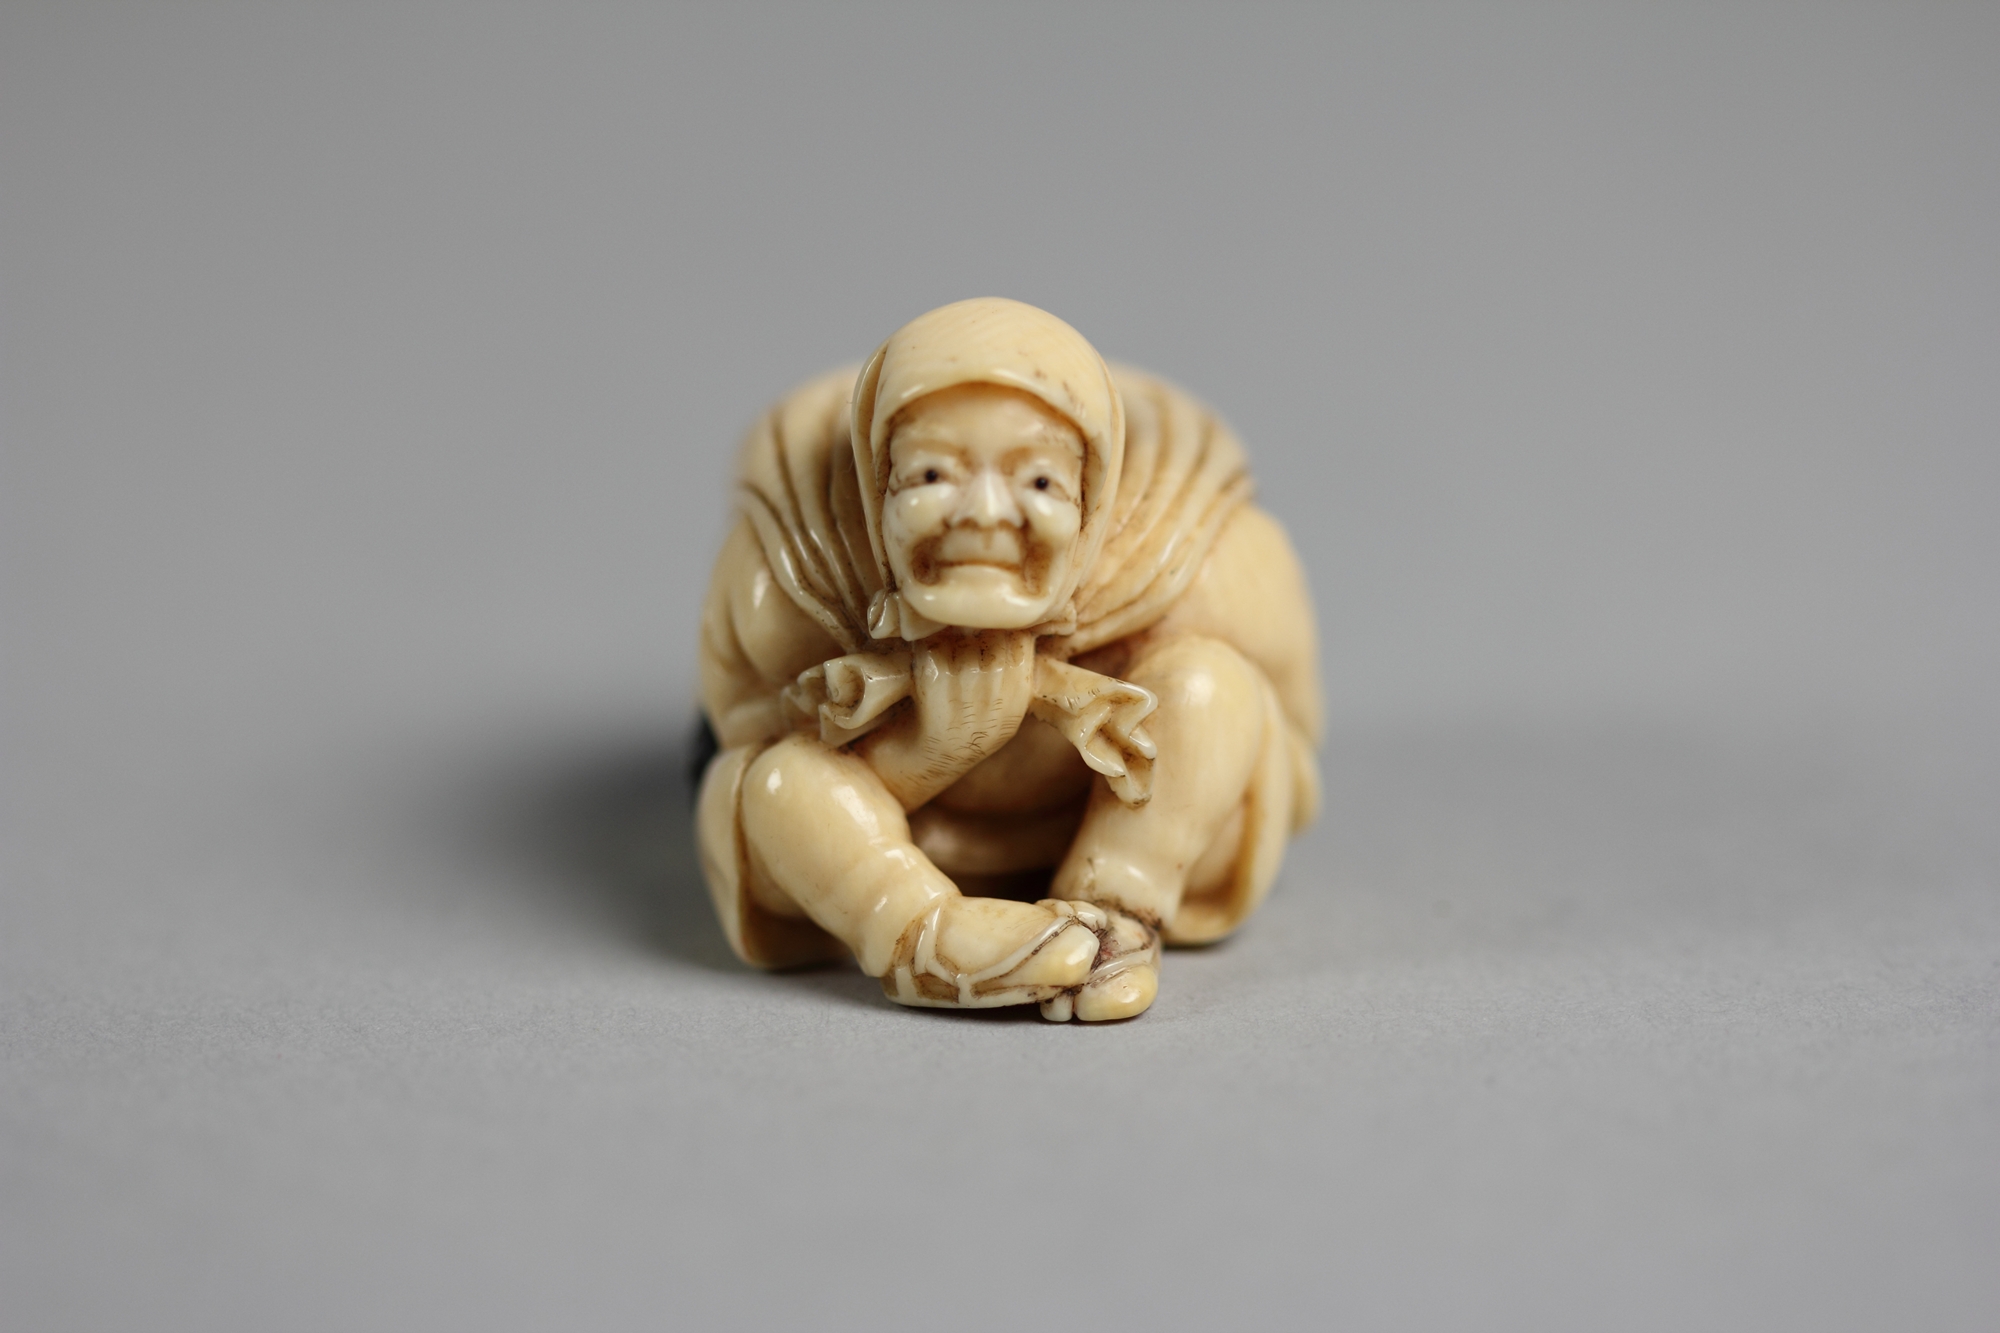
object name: netsuke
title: Netsuke of Old Man Carrying a Bag of Ōni (Demons)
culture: japanese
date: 1801-1900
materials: ivory, metal, wood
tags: men